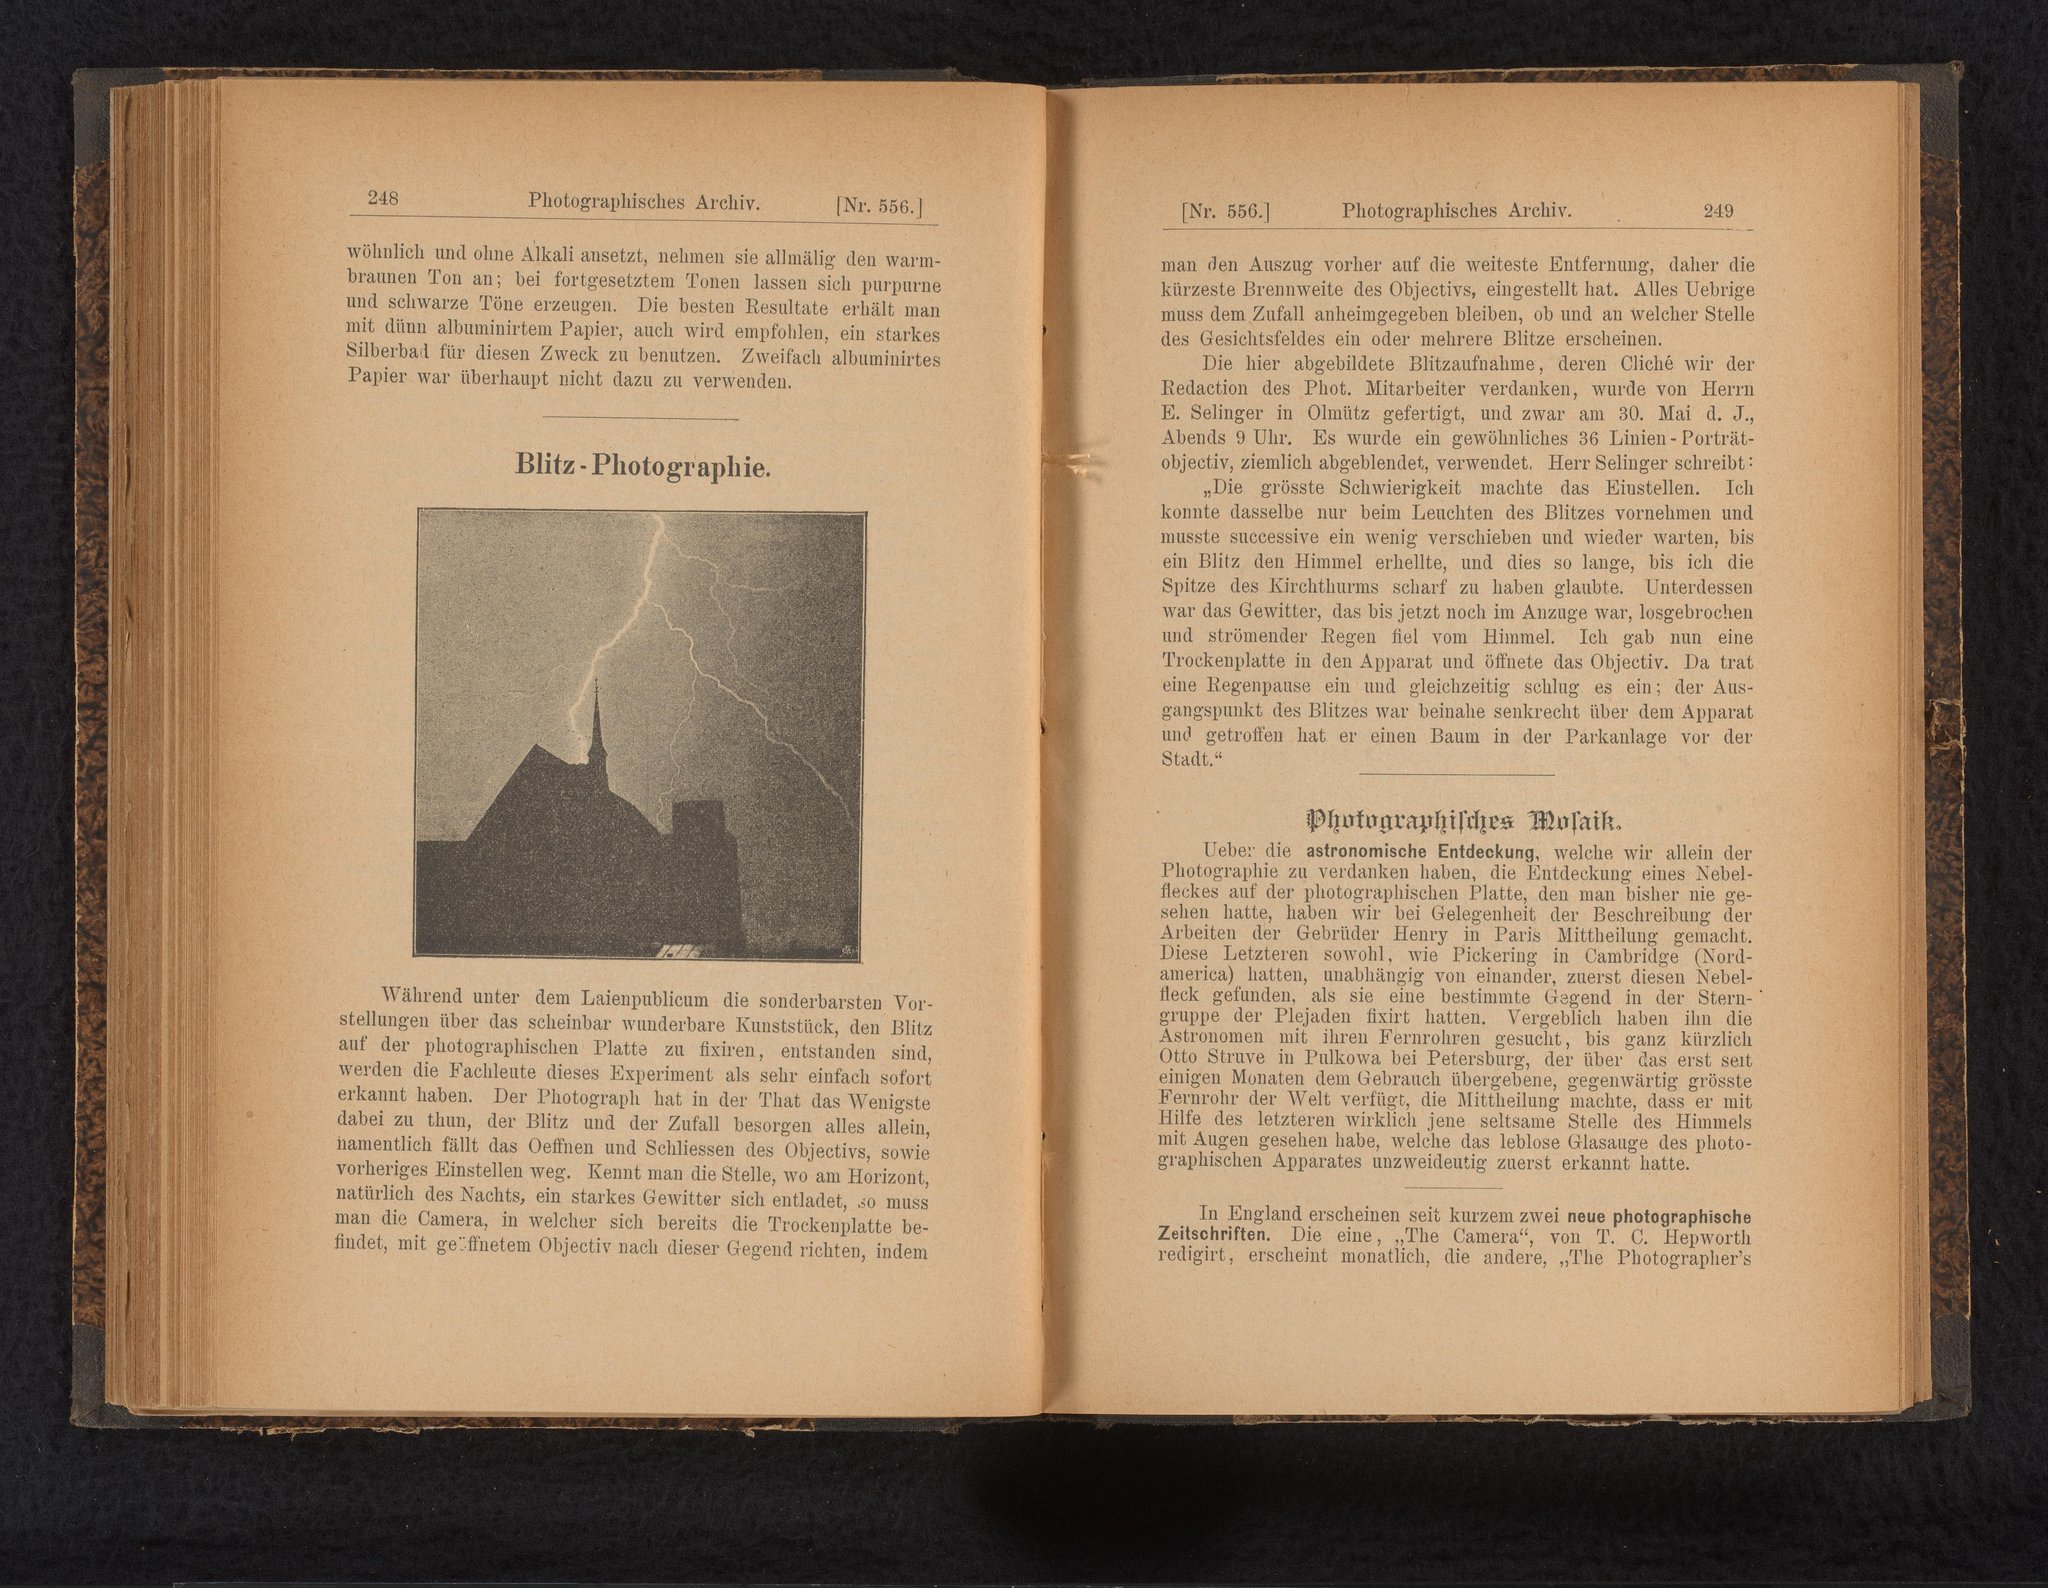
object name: photomechanical print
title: Blitz-Photographie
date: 1886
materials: paper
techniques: autotype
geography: olomouc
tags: lightning, flash of lightning, thunderbolt, parts of church exterior and annexes: tower